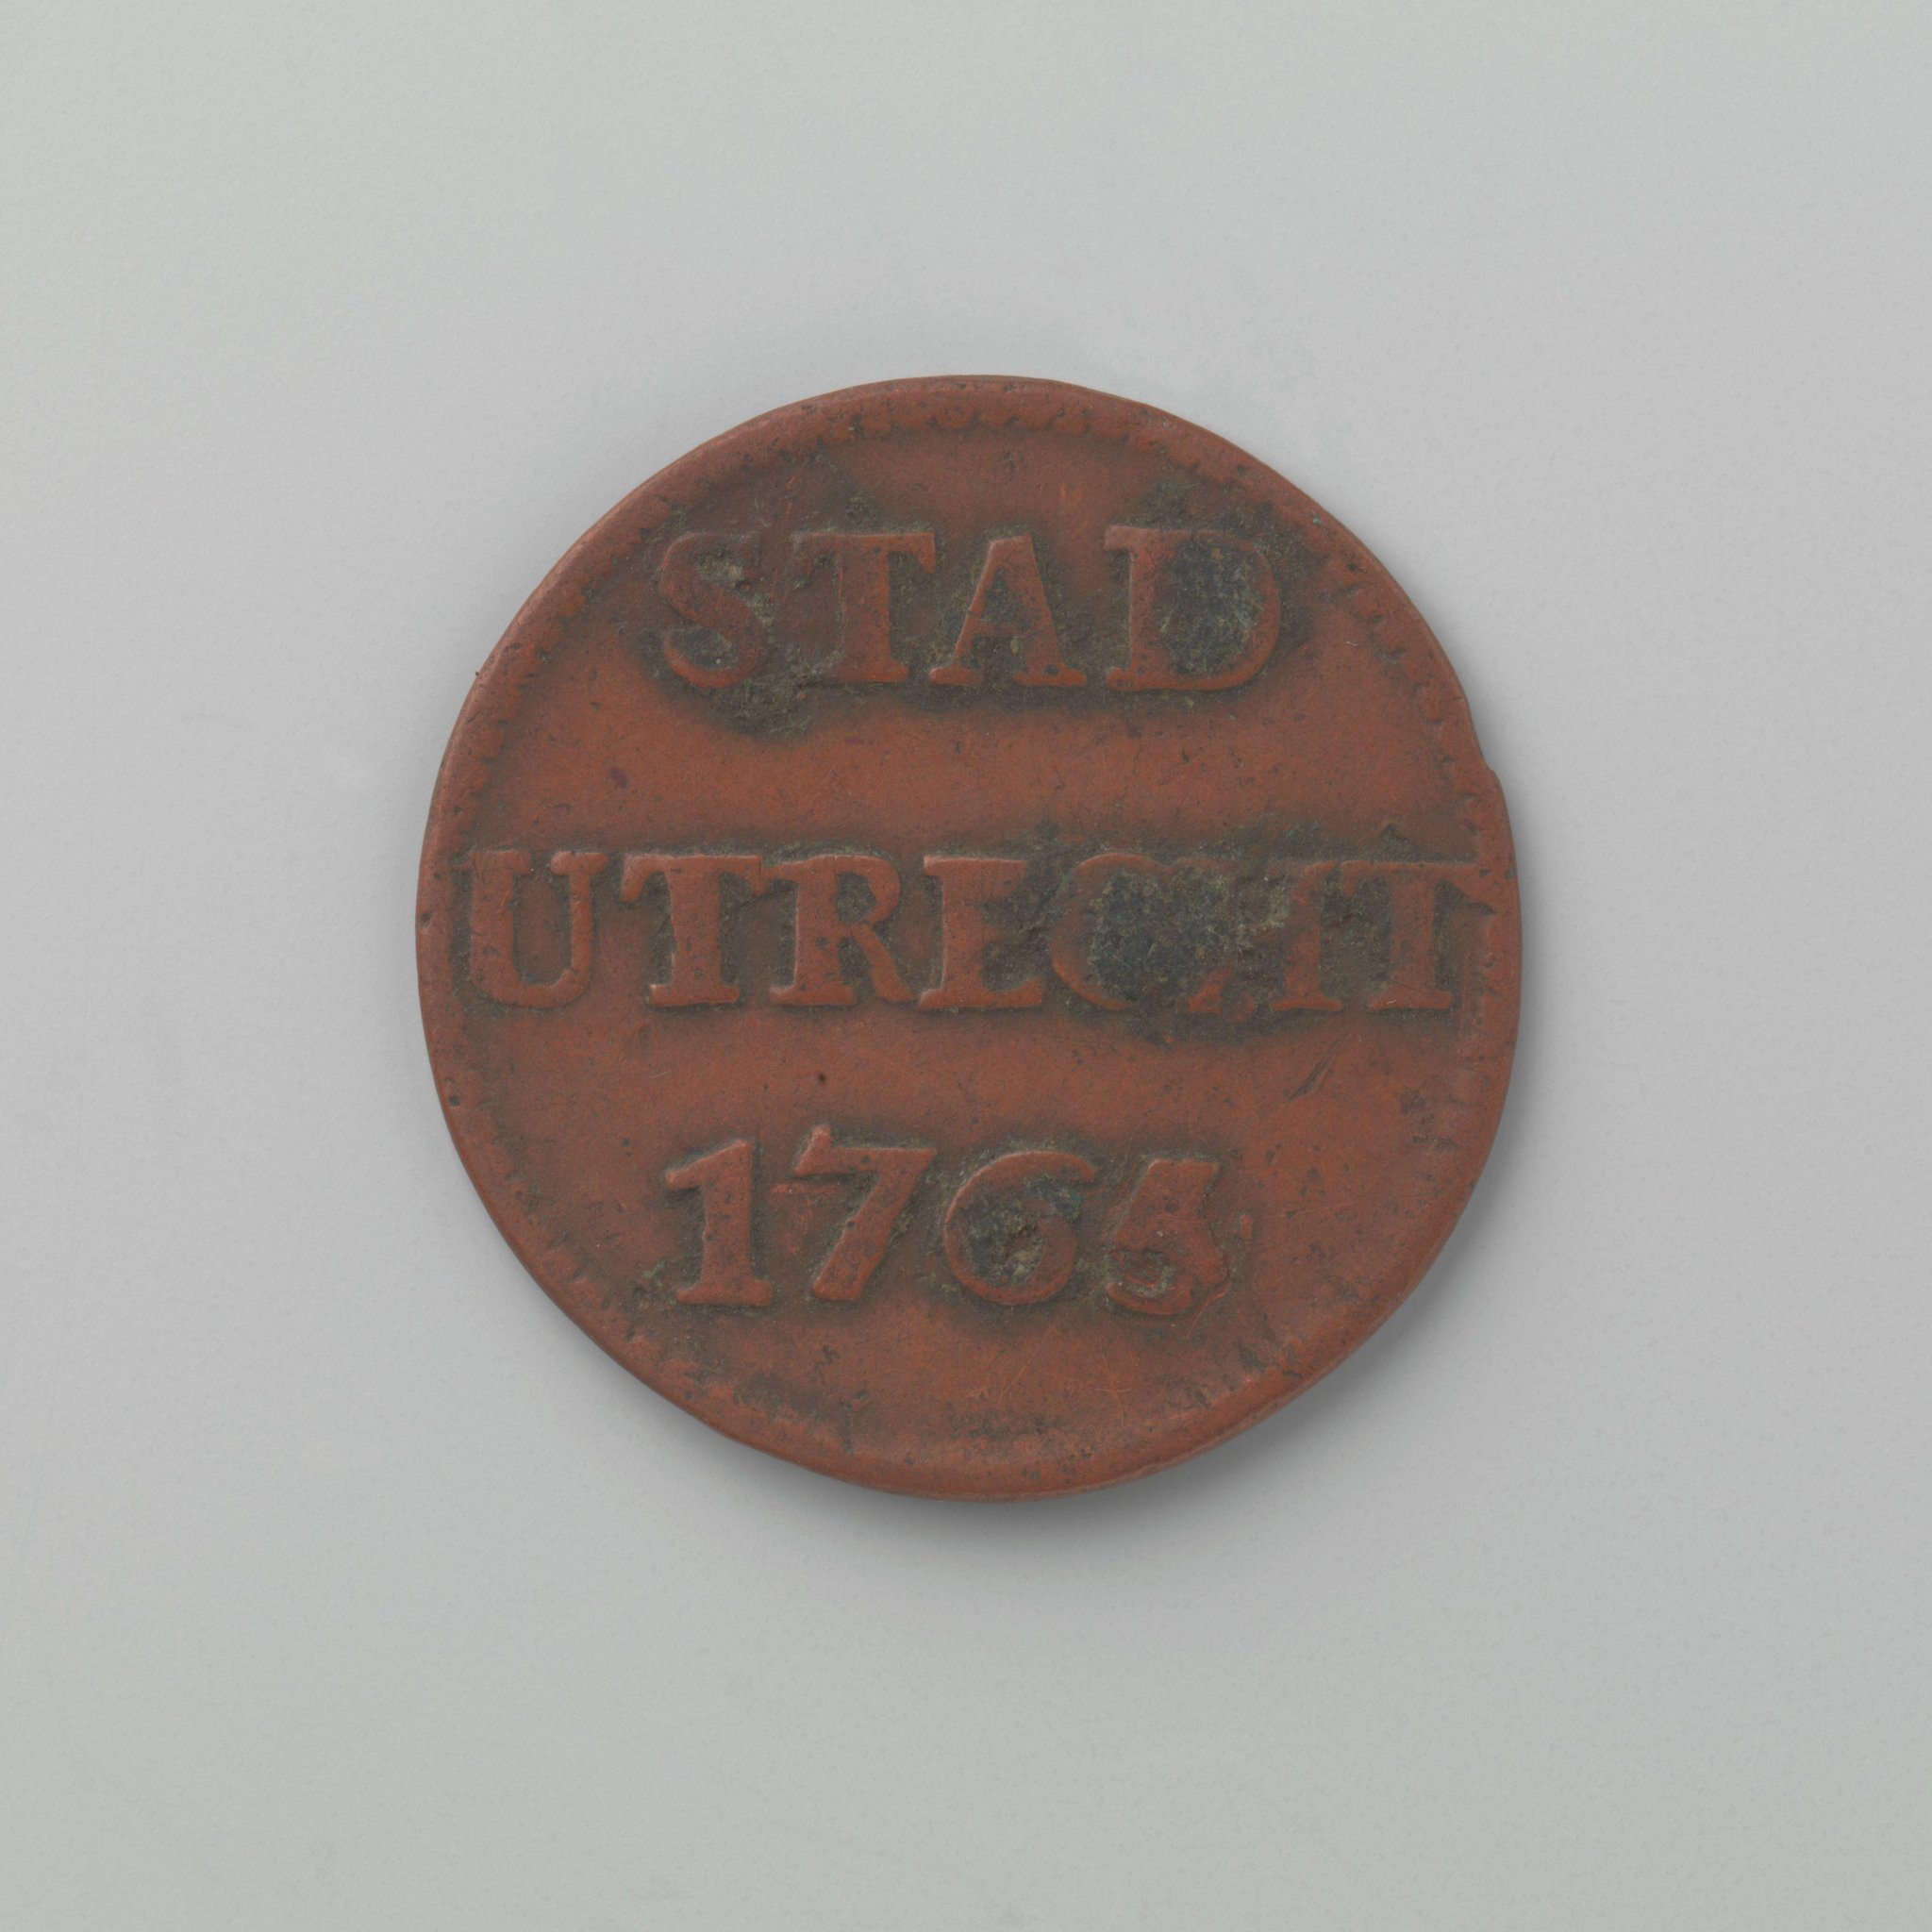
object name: coin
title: Duit van de stad Utrecht, 1765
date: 1765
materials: copper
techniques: striking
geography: utrecht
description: Koperen munt. Voorzijde: gekroond stedelijk wapenschild, gehouden door twee leeuwen met in afsnede dikke lijn, waaronder een versierde accolade met een grote schelp. Keerzijde: opschrift in twee regels, waaronder jaartal. Jaartal met Arabische 1.